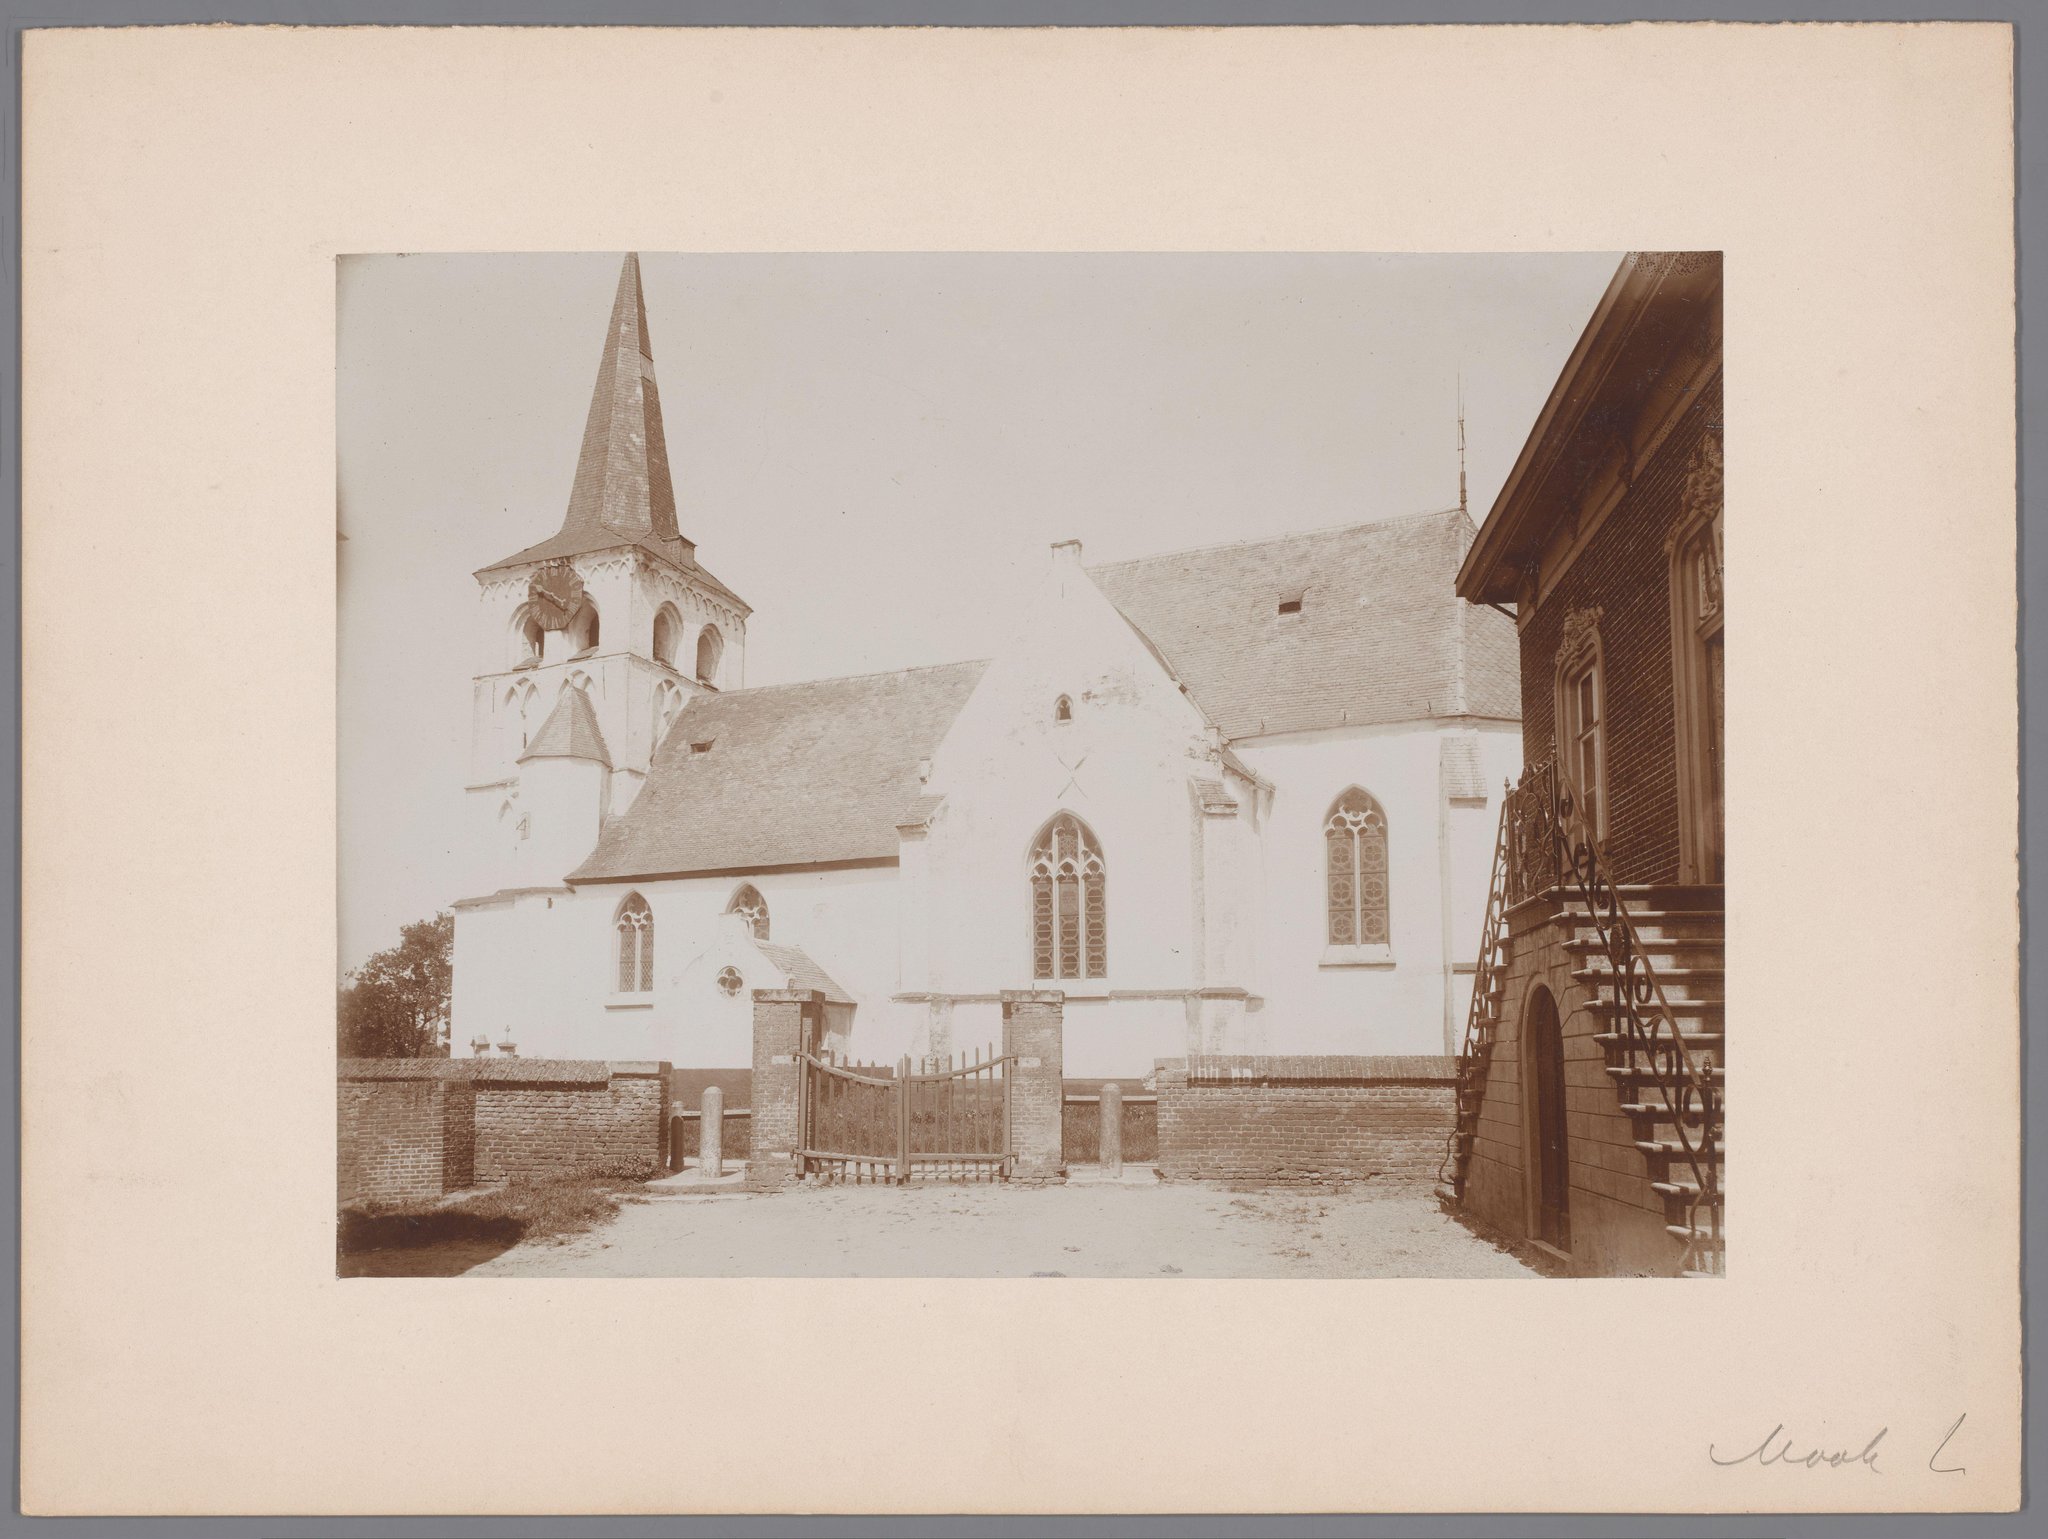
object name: photograph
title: Gezicht op de Sint-Antonius Abtkerk te Mook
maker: anoniem (monumentenzorg)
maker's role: fotograaf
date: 1906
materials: cardboard, photographic support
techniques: collodion silver print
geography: mook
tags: church (exterior)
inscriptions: annotation: ‘R.K. Kerk te Mook (L.)/ juni 1906’, annotation: ‘Mook L’